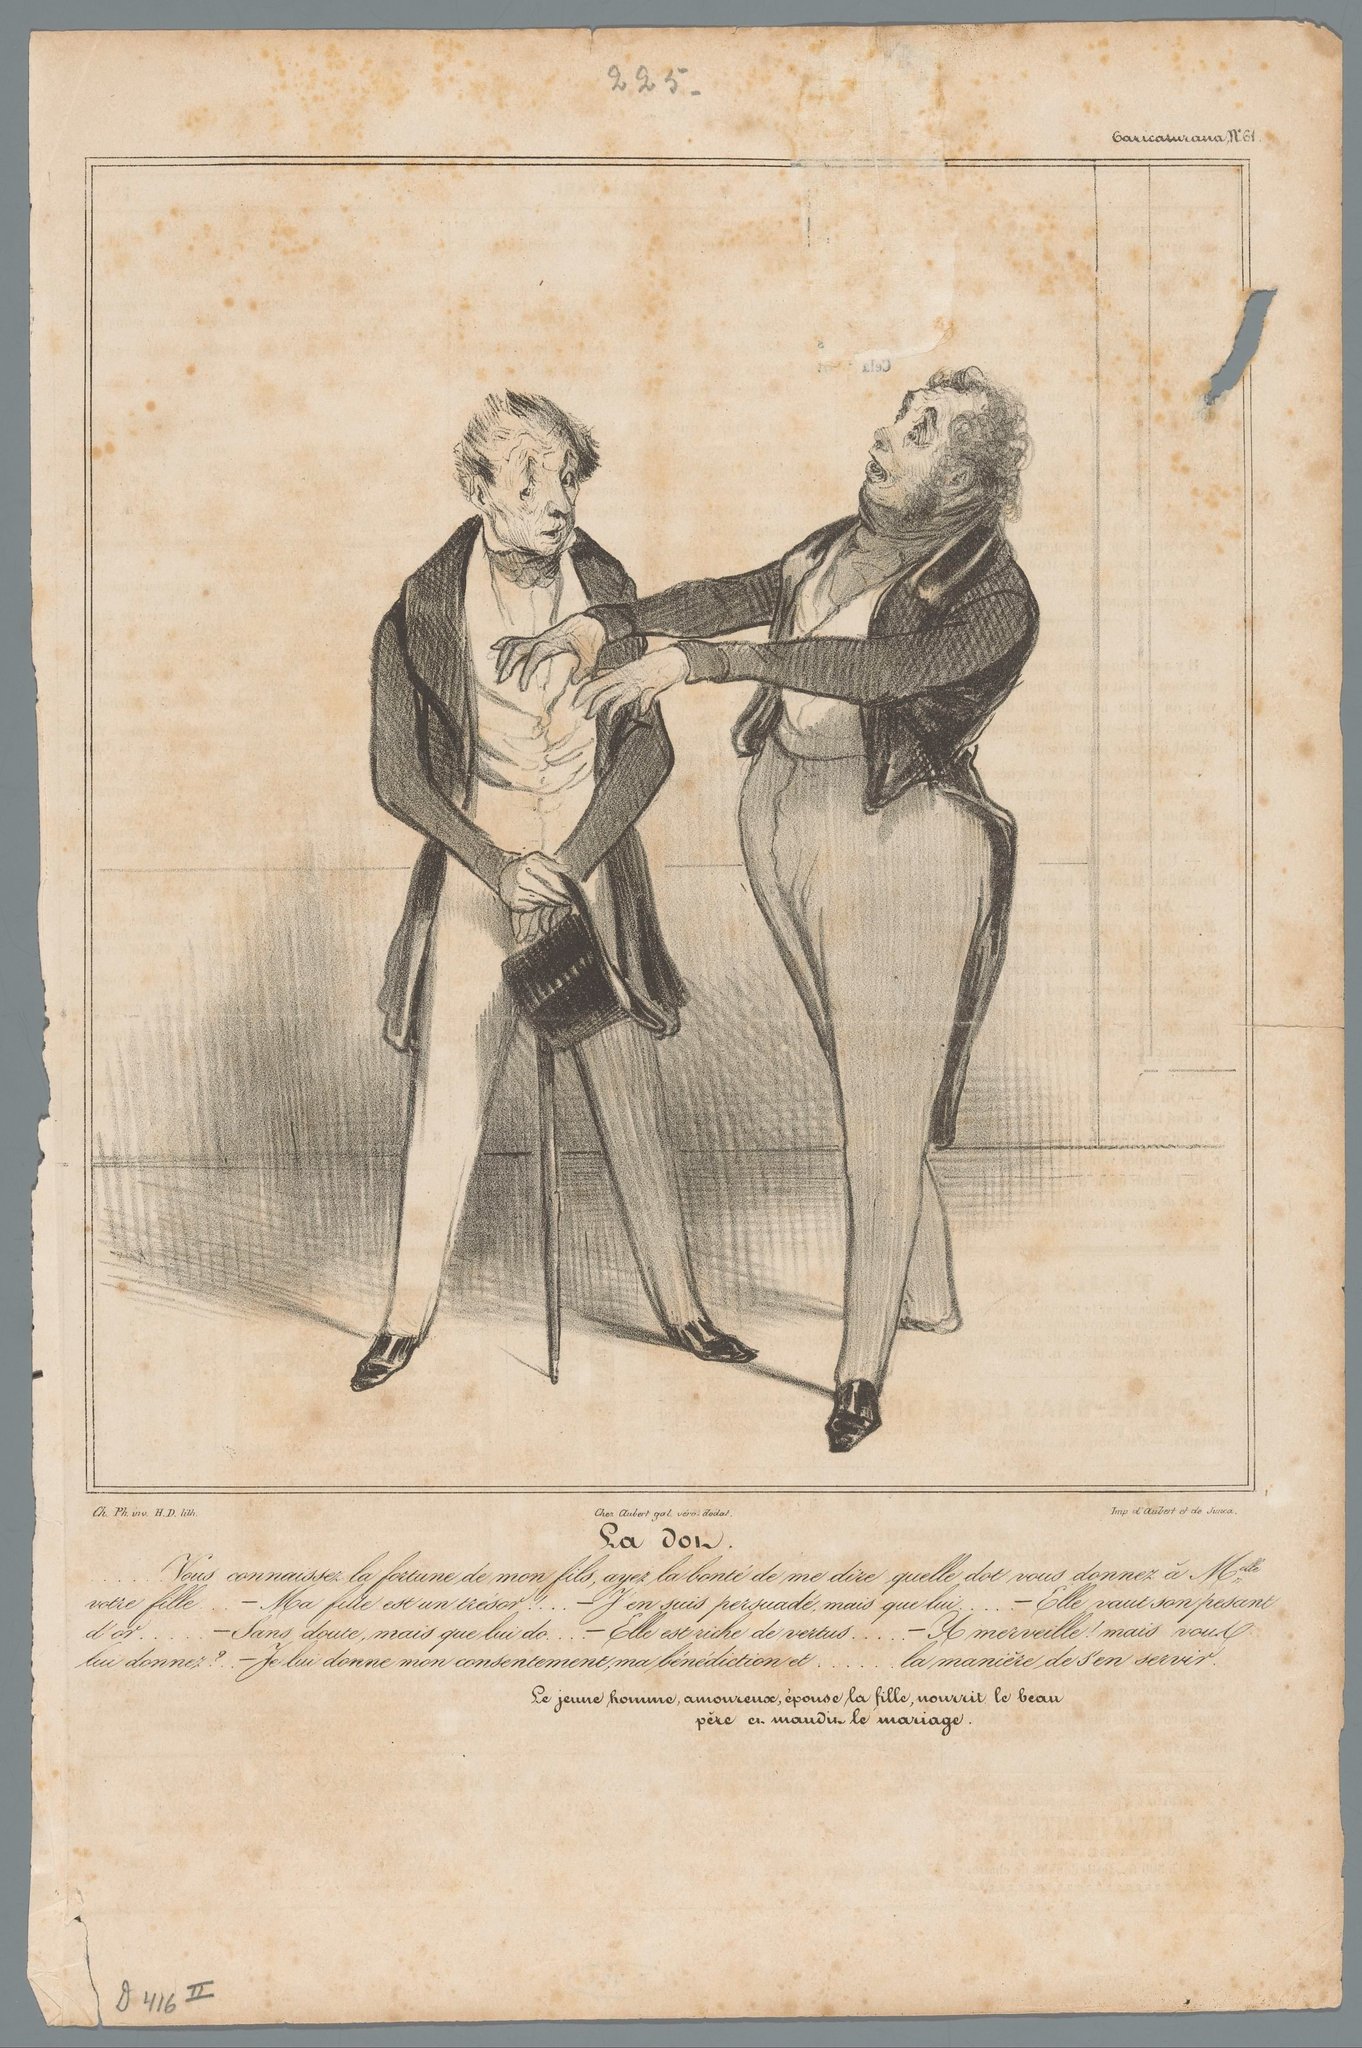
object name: cartoon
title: Karikaturen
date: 1837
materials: paper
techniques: letterpress printing, lithograph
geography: paris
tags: caricatures (human types), parental blessings and admonitions, dowry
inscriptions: collector's mark: Lugt 2228a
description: Prent mogelijk uit: Le Charivari, 10 september 1837.